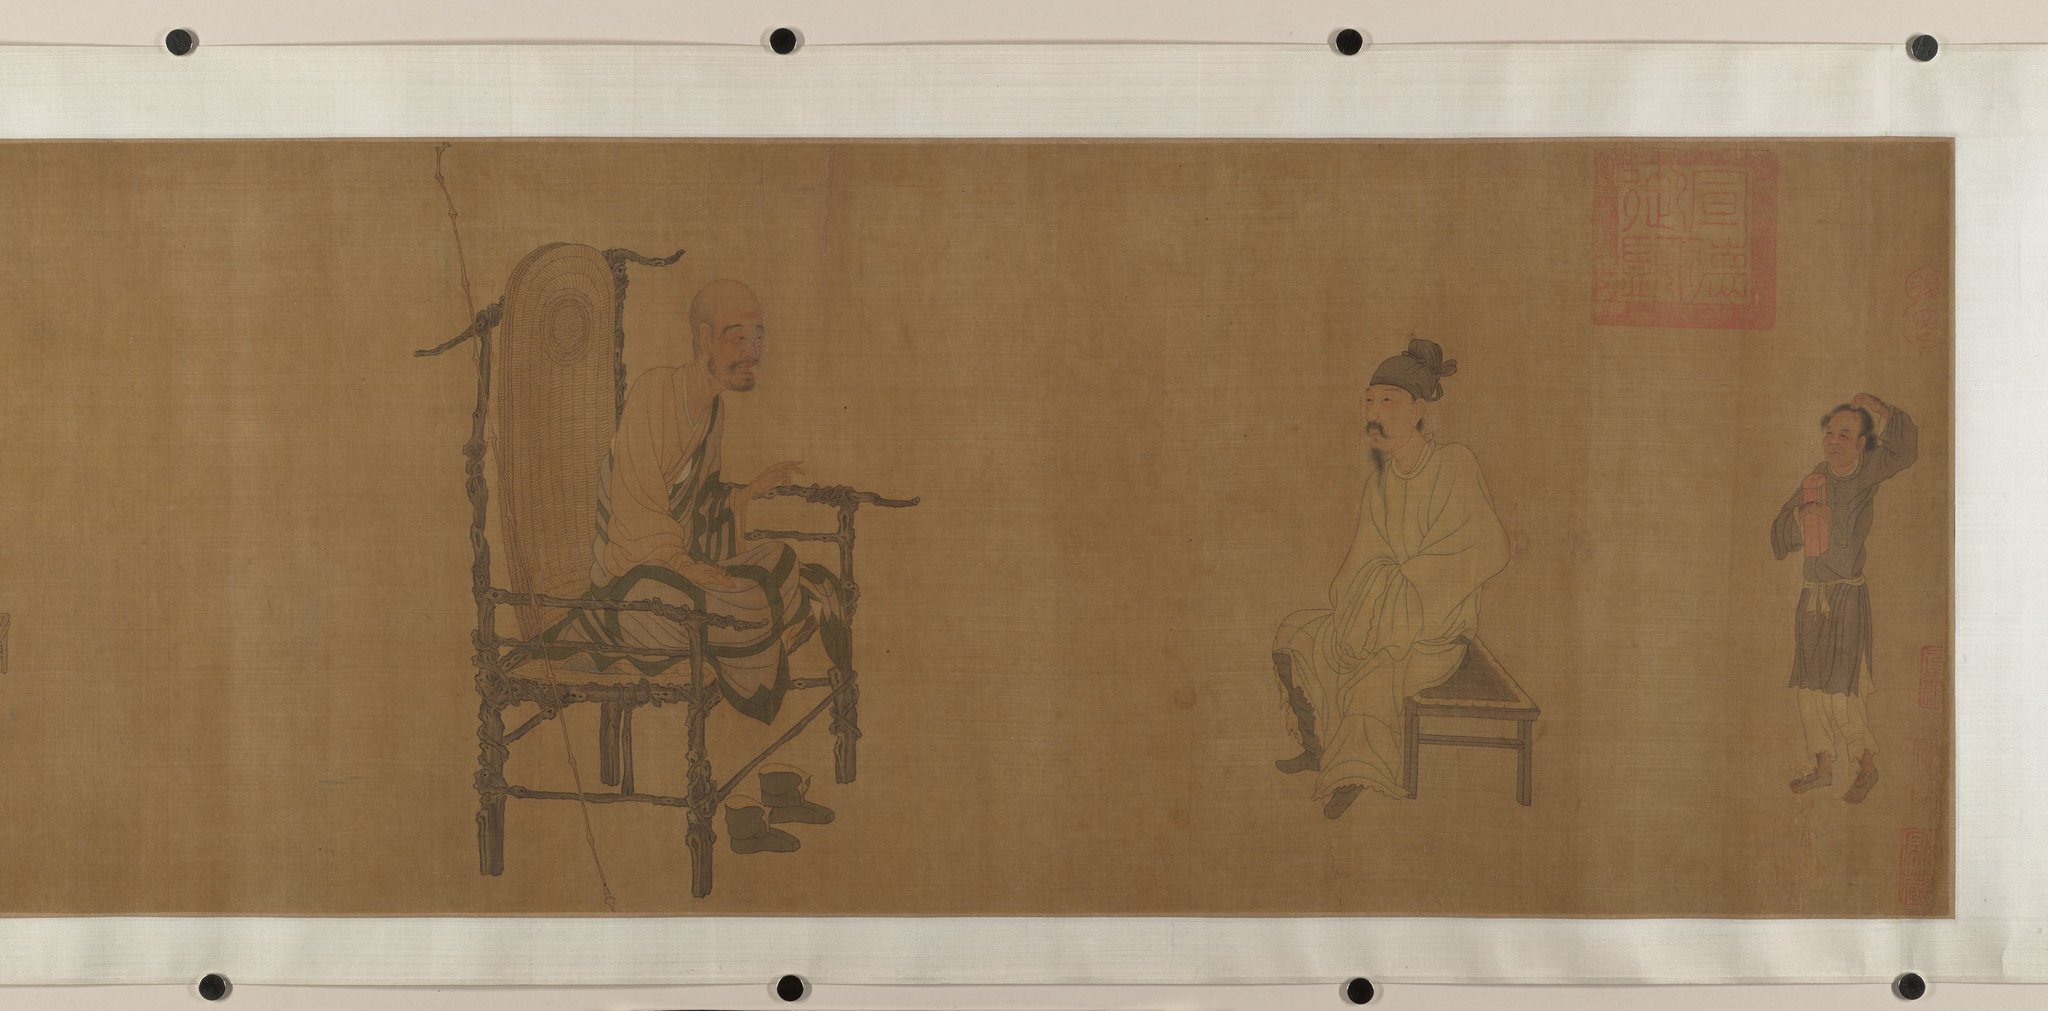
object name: handscroll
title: Xiao Yi Obtaining the Lanting Manuscript from the Monk Biancai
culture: chinese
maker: unidentified artist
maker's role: artist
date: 1368-1911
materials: ink, silk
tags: men,benches,chairs